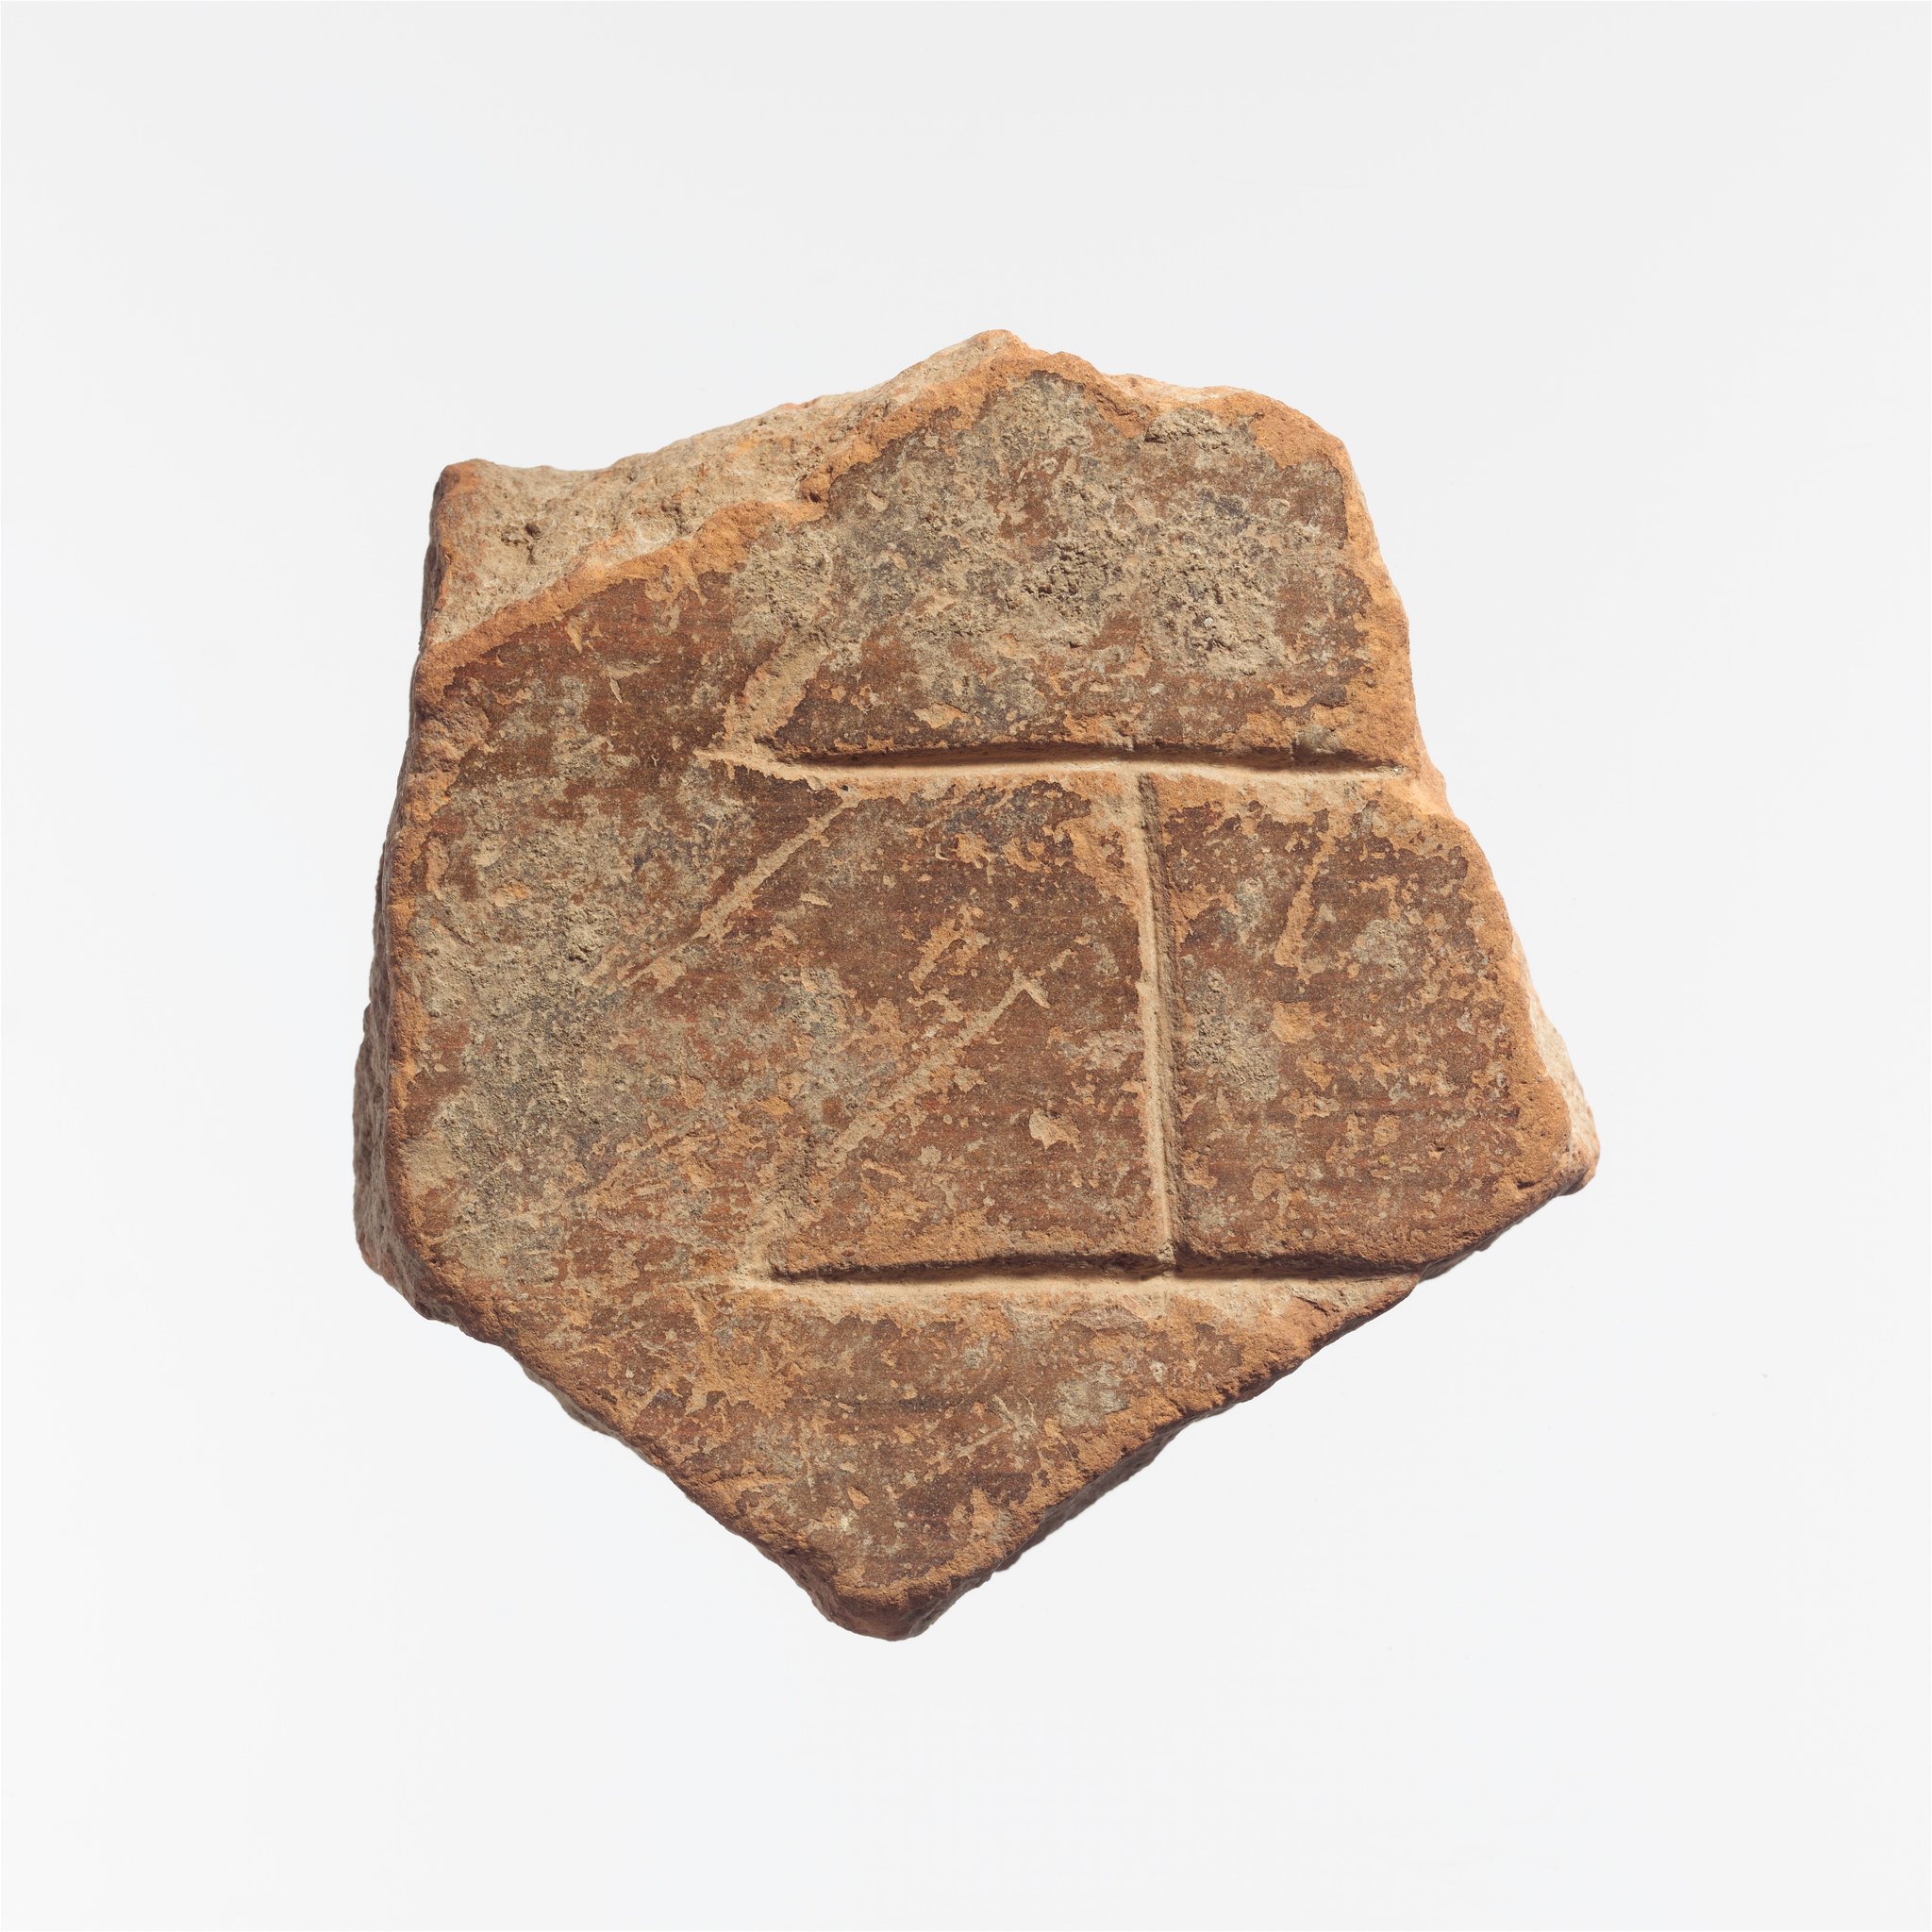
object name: tile fragment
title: Fragment of a terracotta architectural tile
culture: lydian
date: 600-501 BCE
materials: terracotta